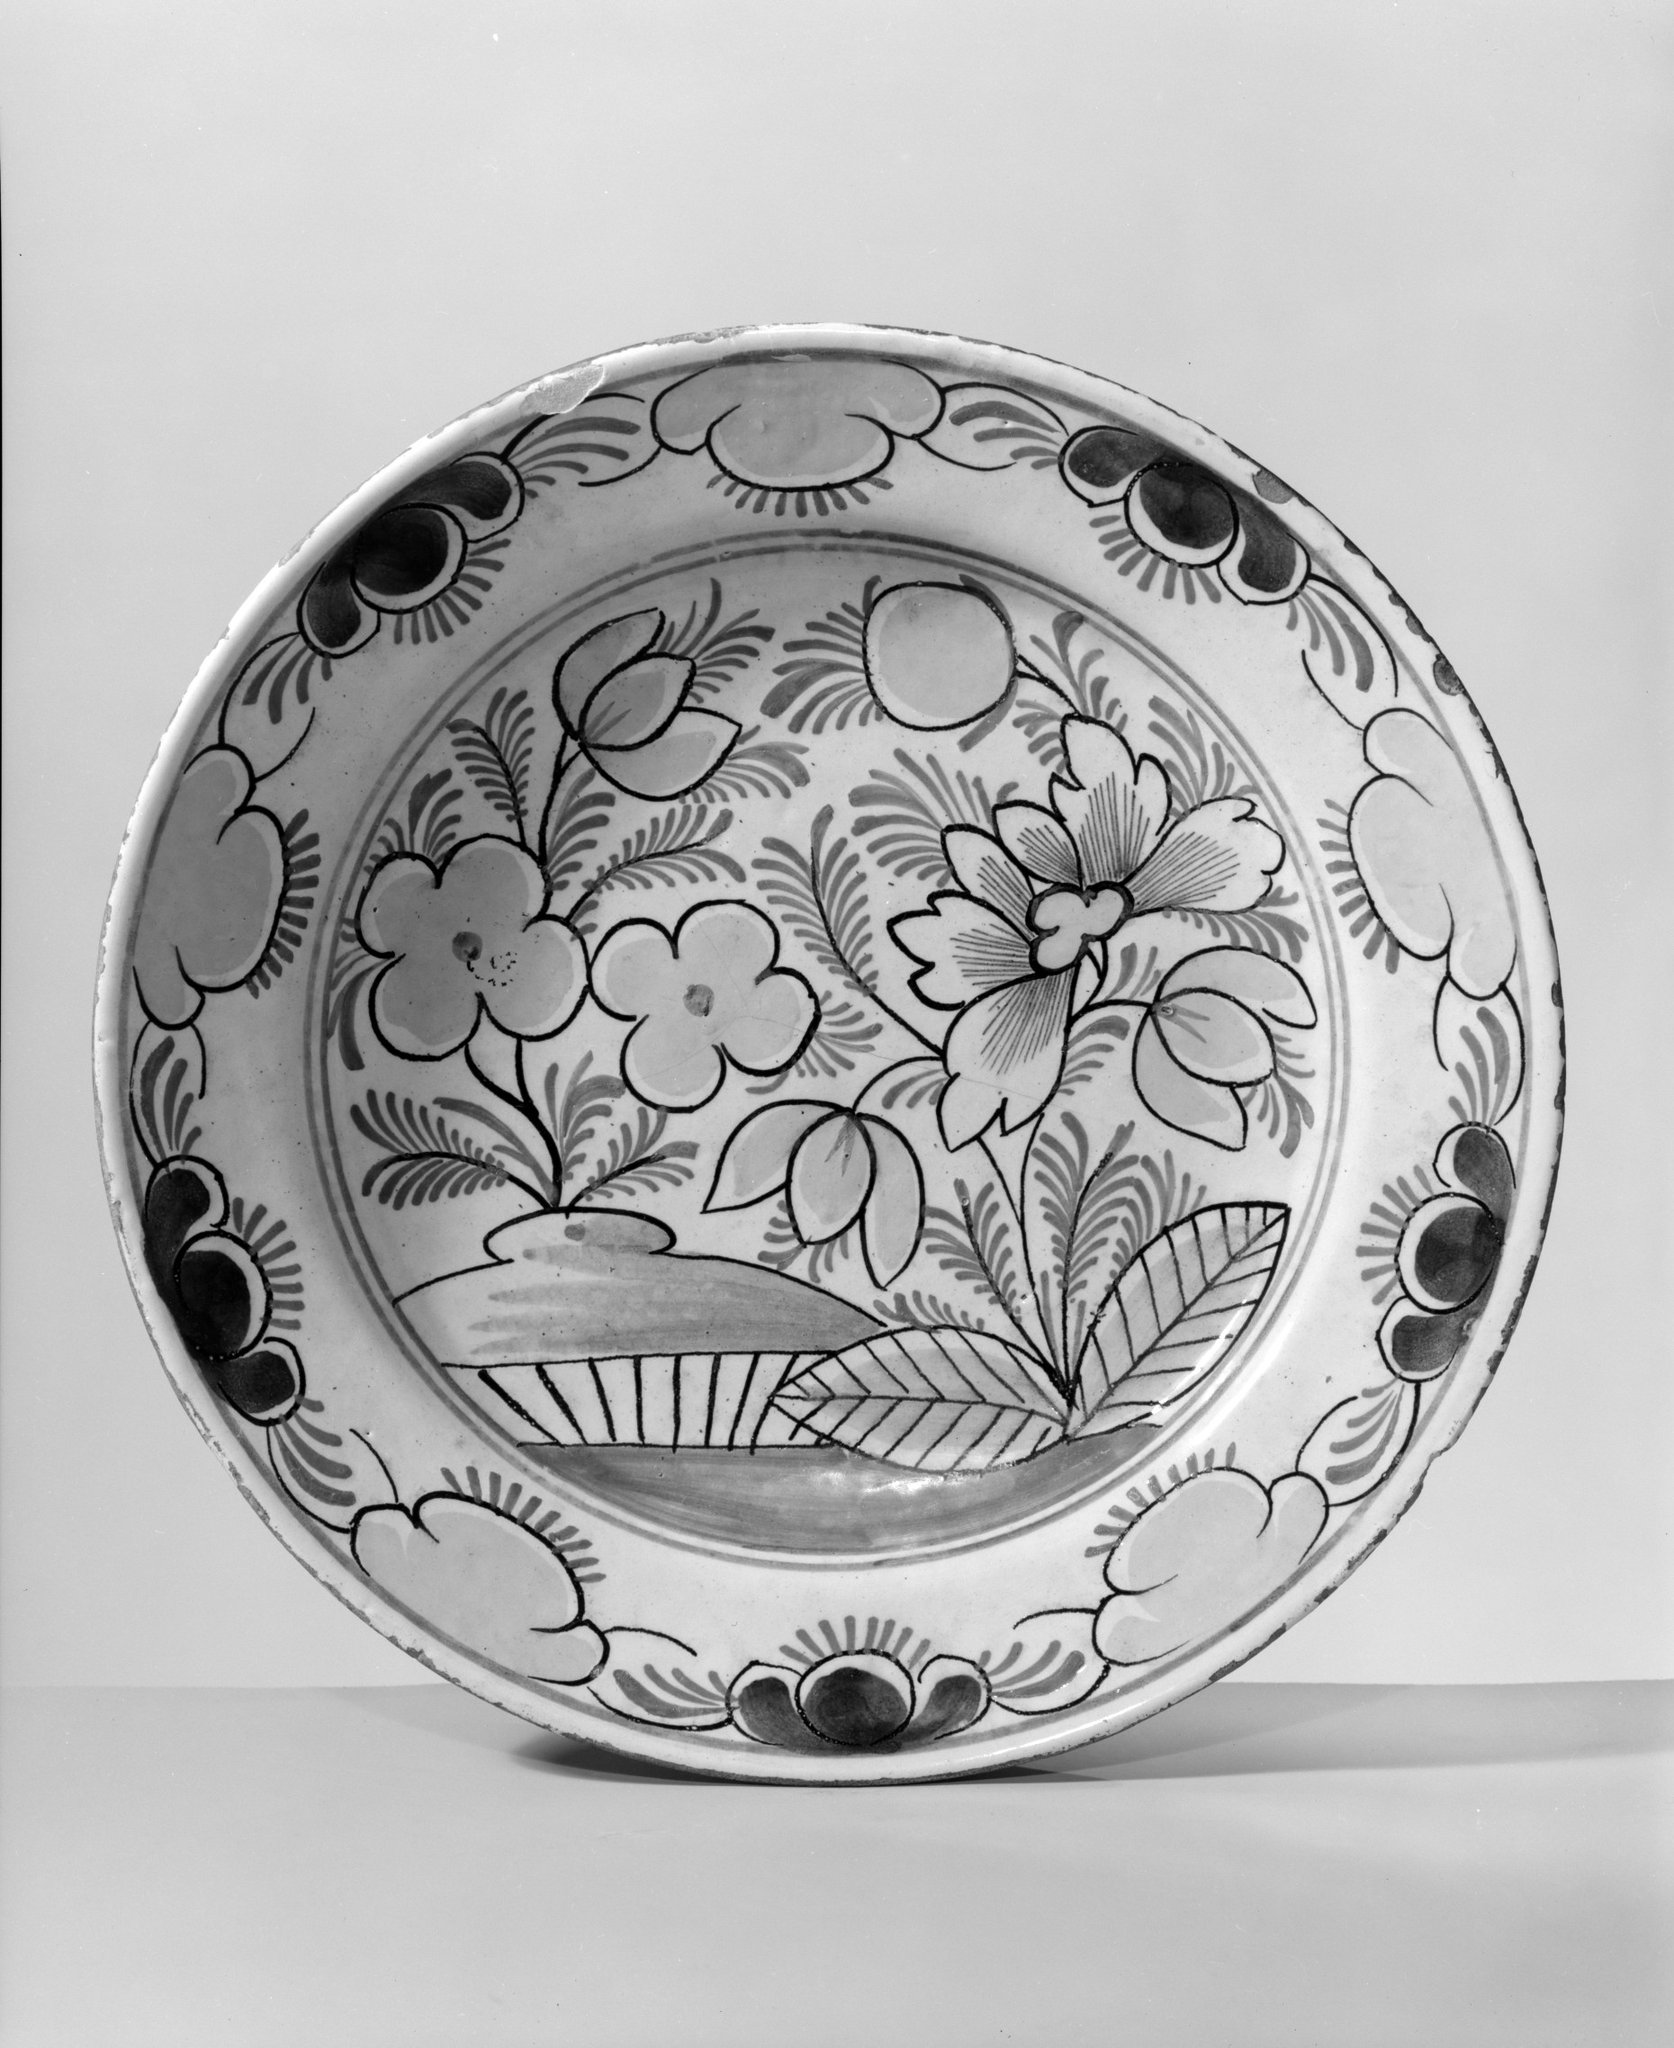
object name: plate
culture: dutch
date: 1700-1800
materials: earthenware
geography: netherlands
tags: flowers